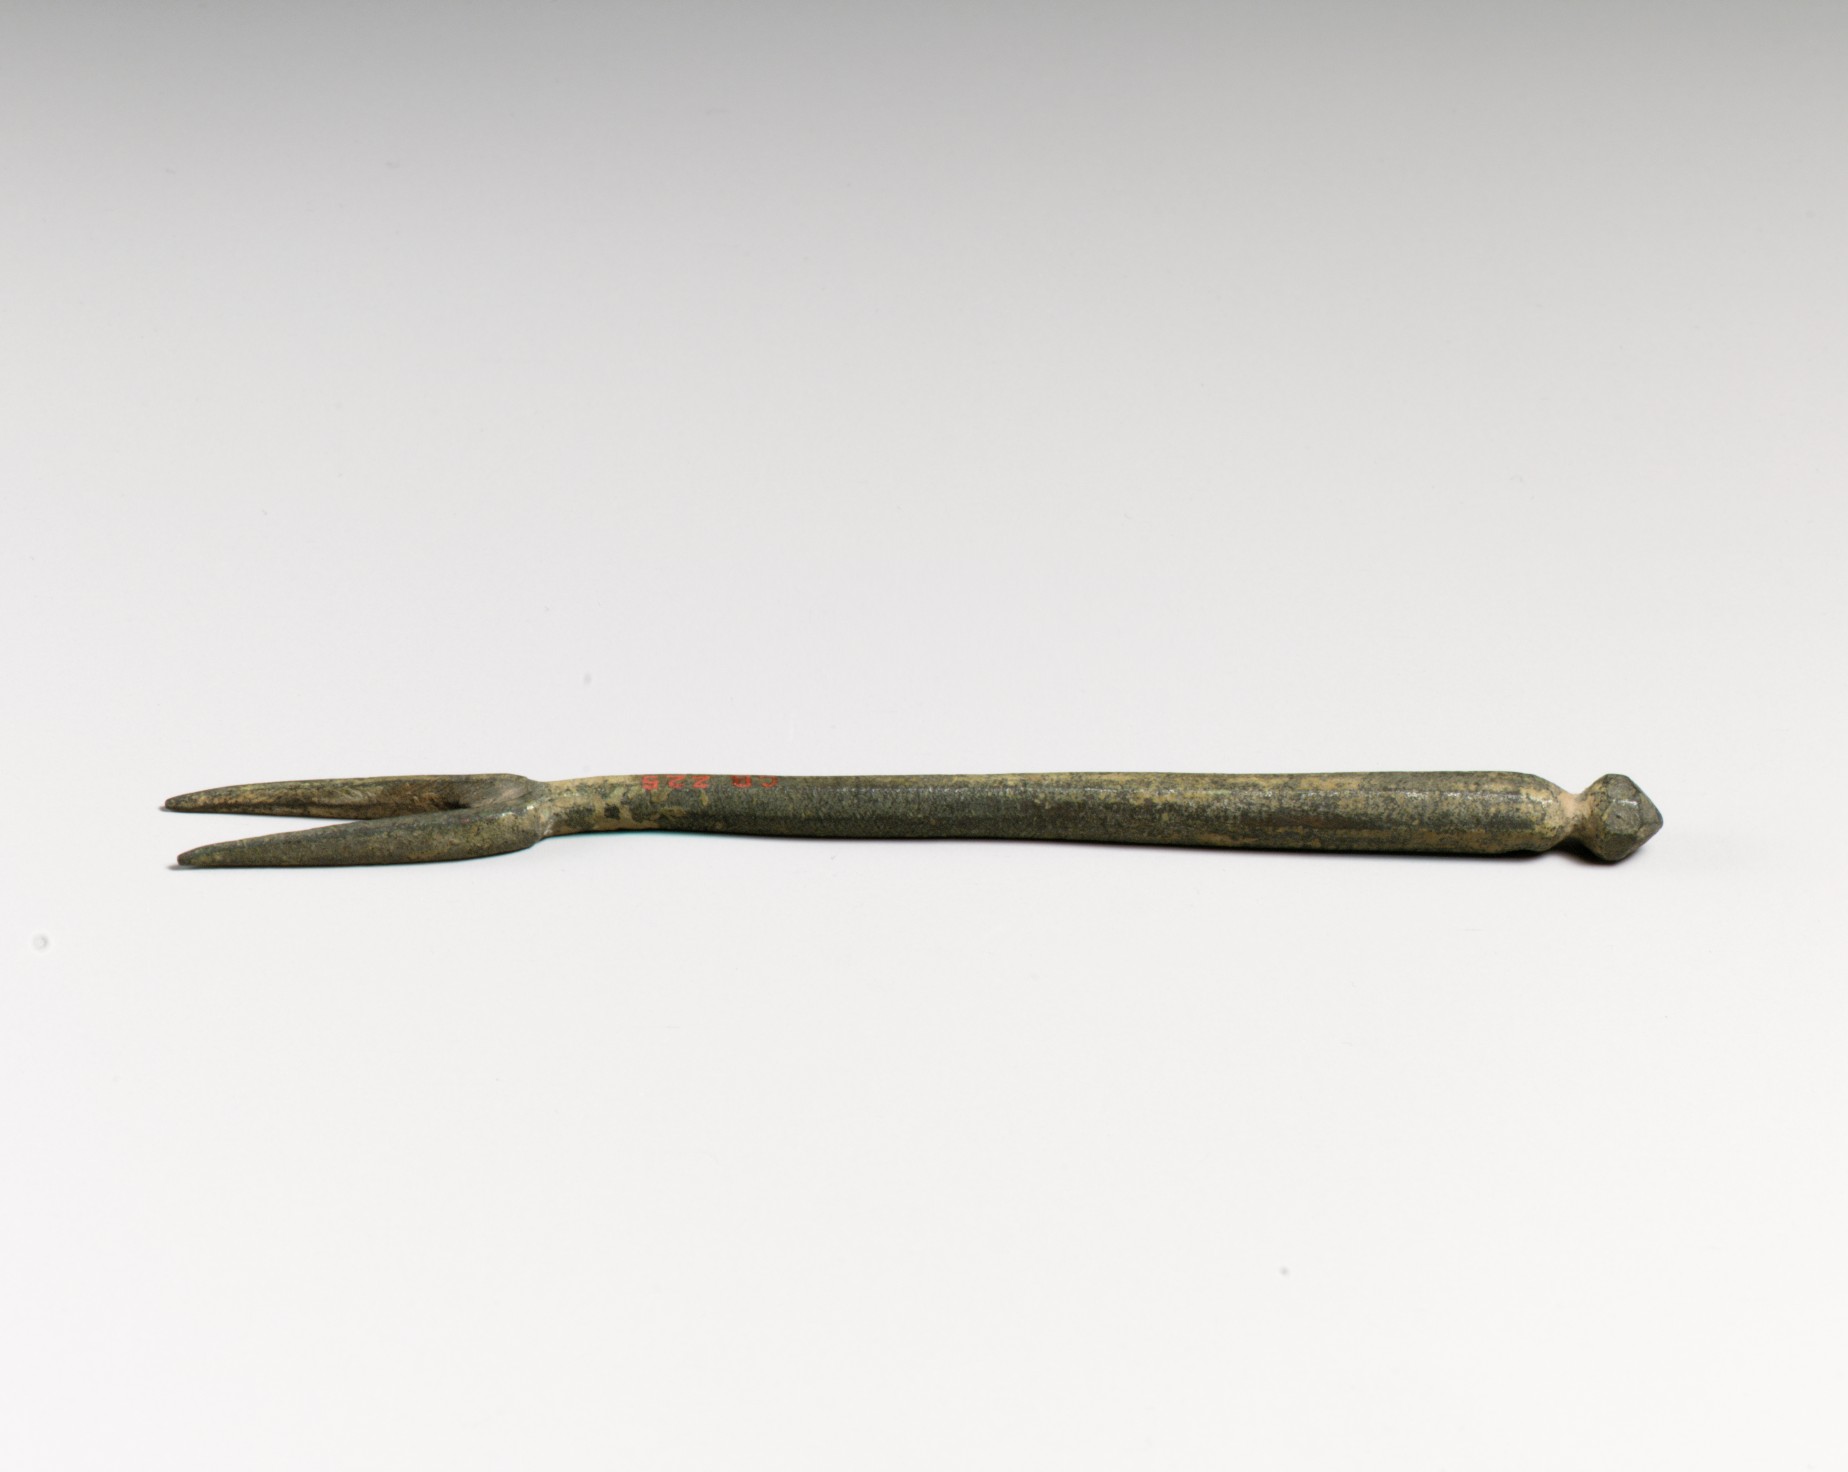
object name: probe fork, bifurcated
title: Bronze fork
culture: roman, cypriot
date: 1-300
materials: bronze